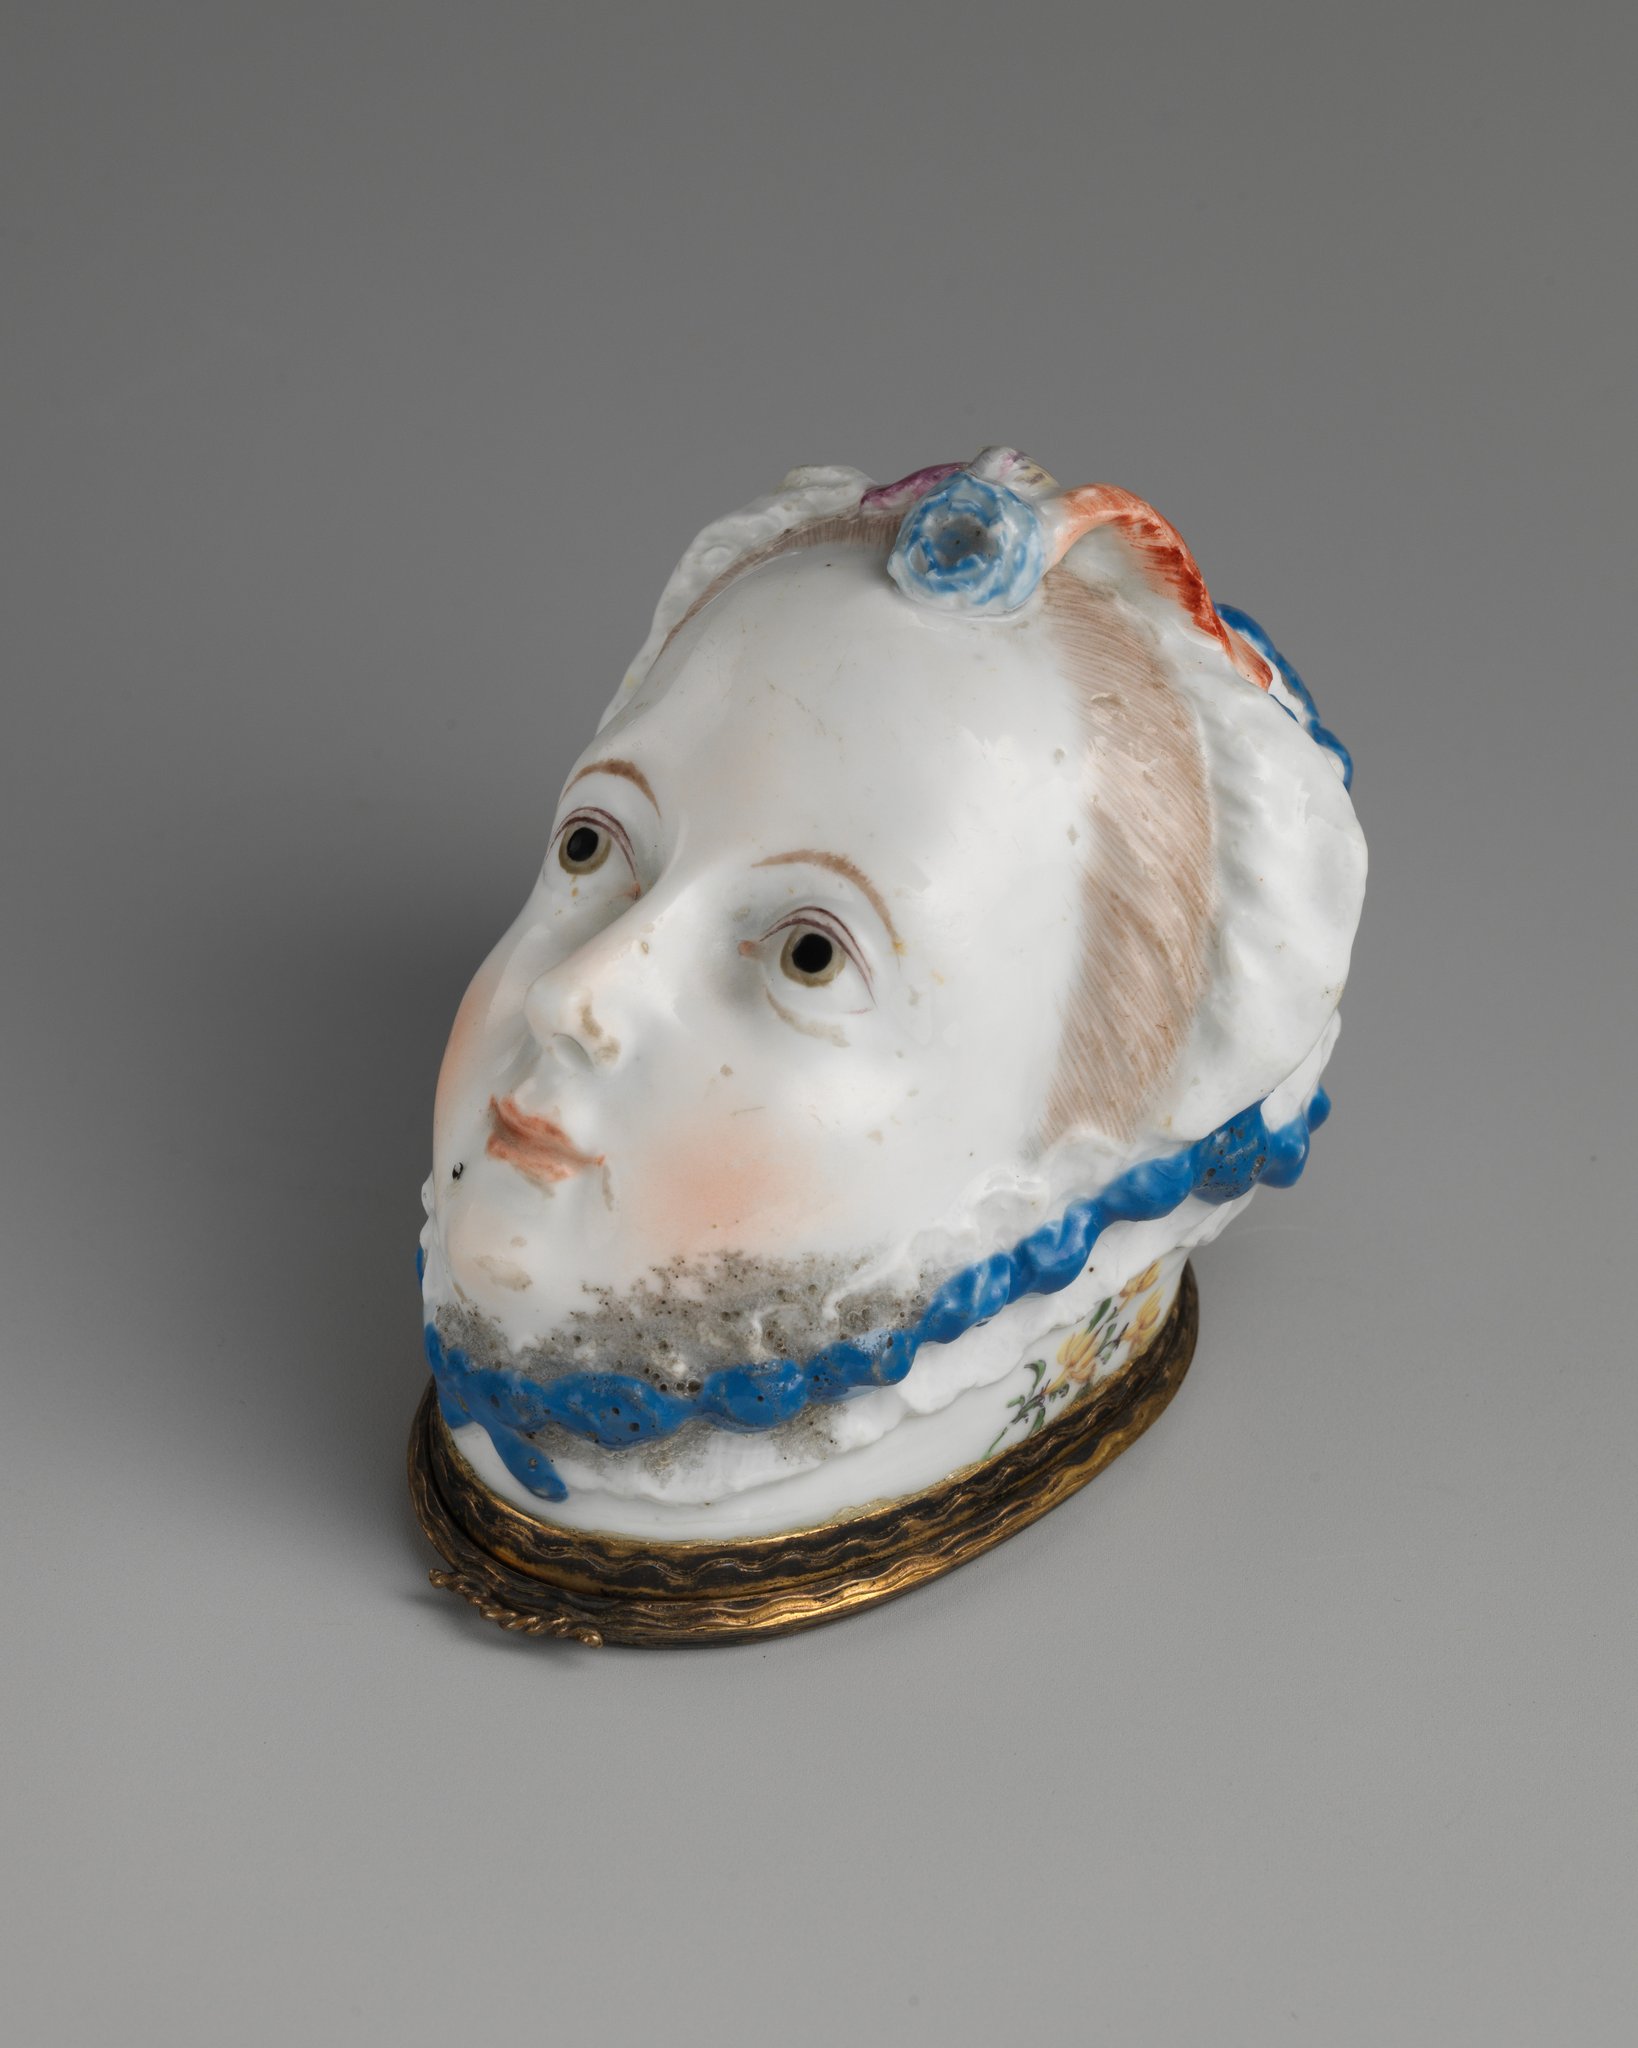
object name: toy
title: Lady's head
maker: chelsea porcelain manufactory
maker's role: factory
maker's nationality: british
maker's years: 1744-1784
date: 1760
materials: soft paste porcelain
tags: heads,women